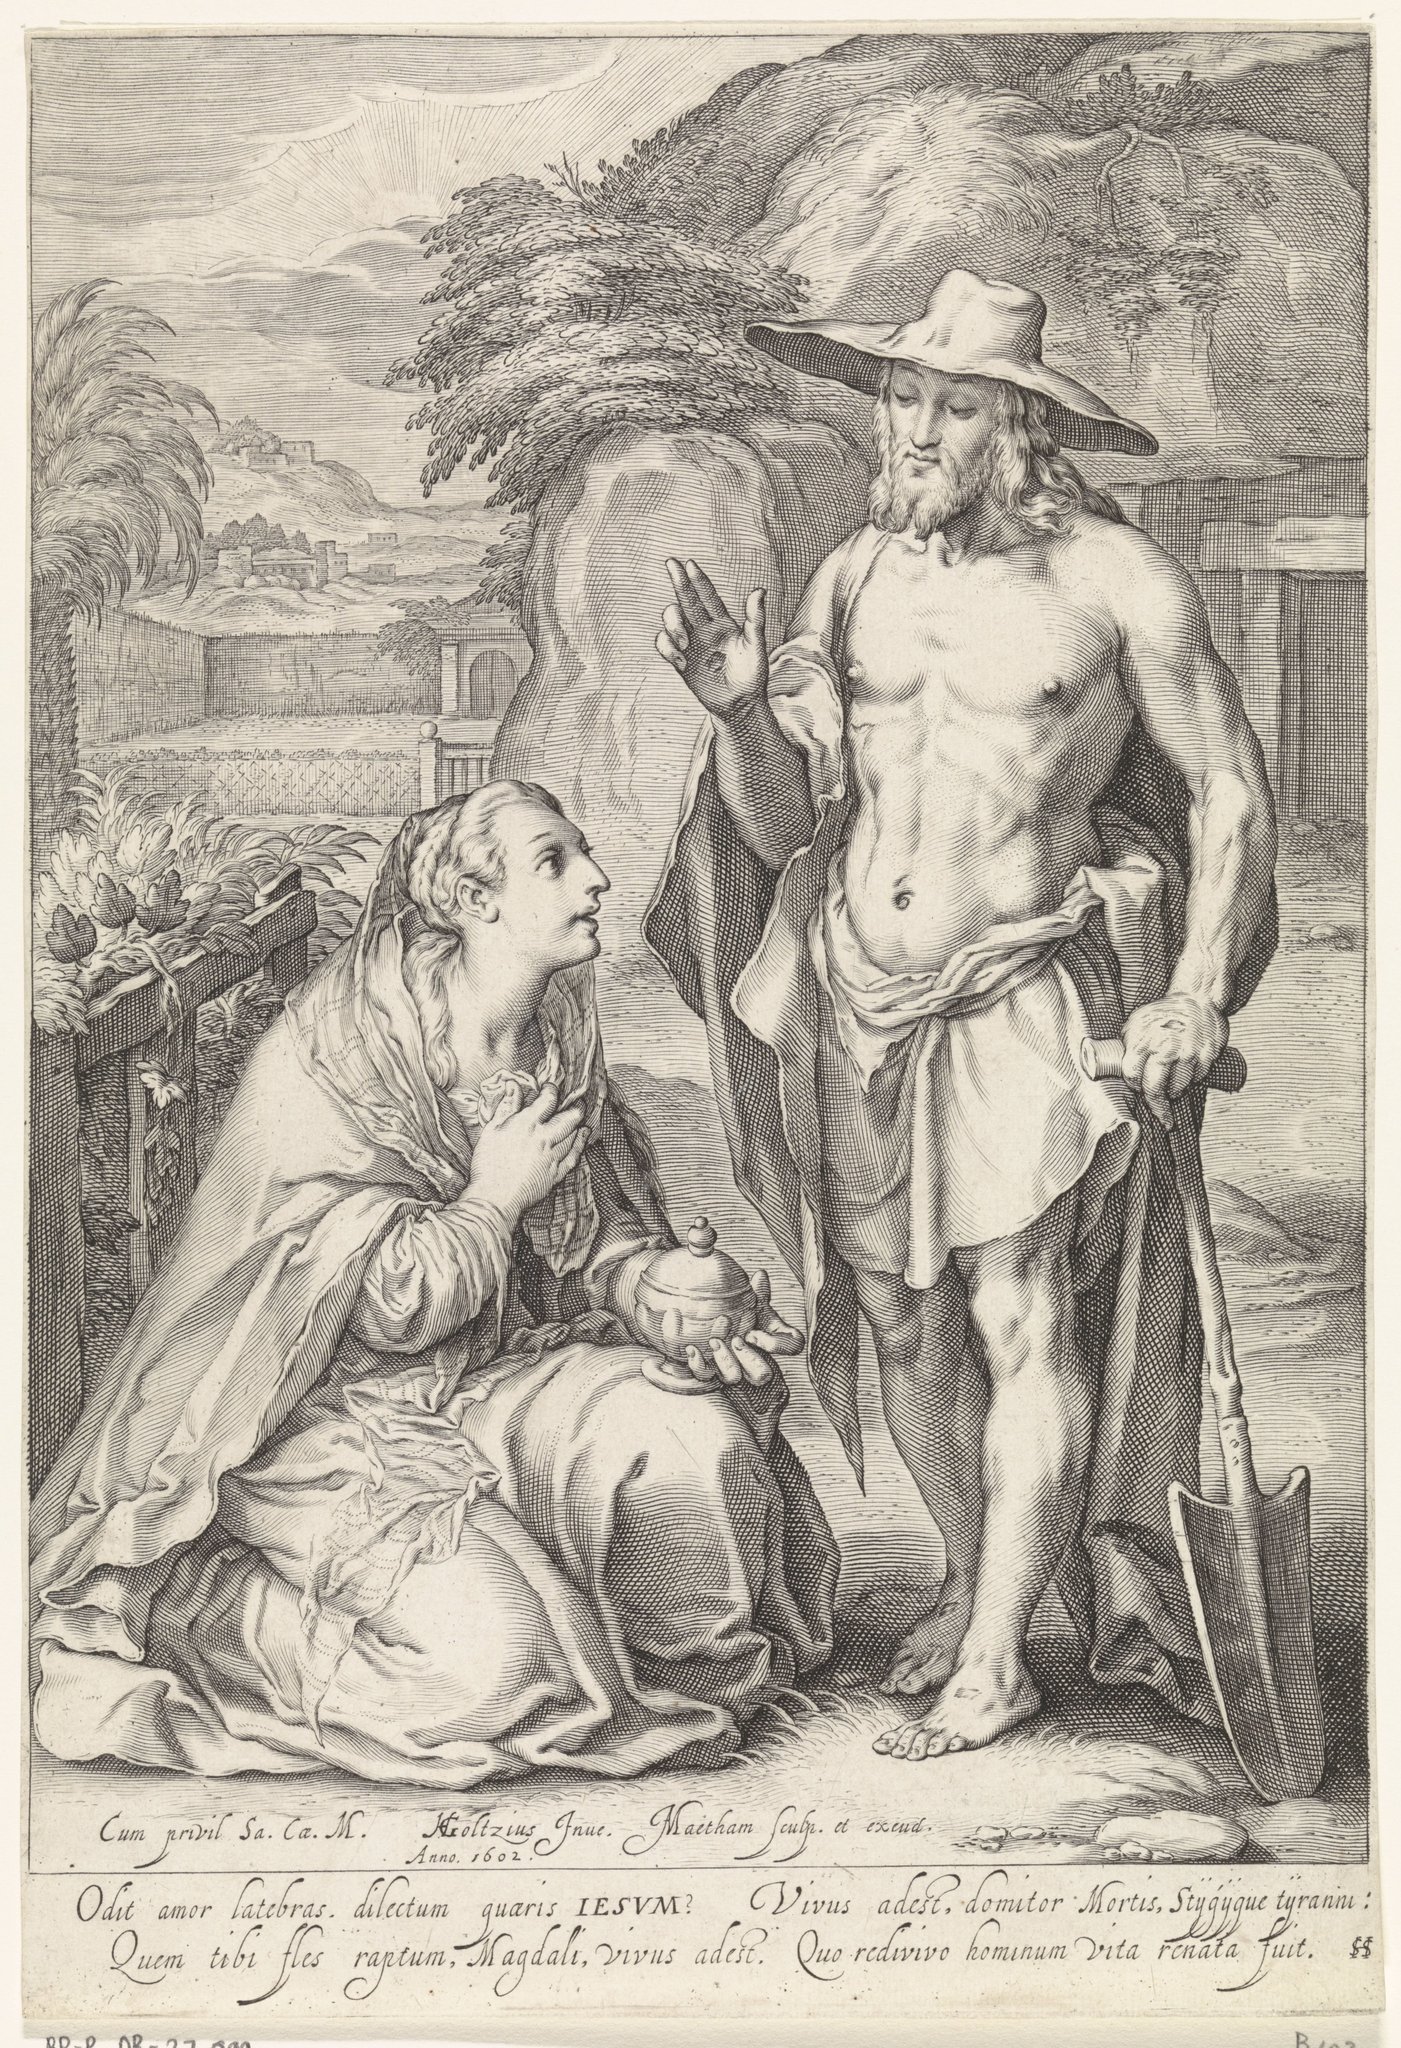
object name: print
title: Christus verschijnt aan Maria Magdalena (Noli me tangere)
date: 1602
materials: paper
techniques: engraving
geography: haarlem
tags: mary magdalene kneeling before christ, who is usually represented as a gardener with a hoe and/or a spade; 'noli me tangere'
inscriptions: caption: ‘Odit amor latebras...’, collector's mark: Lugt 240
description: Maria Magdalena knielt voor Christus die is voorgesteld als een tuinman.